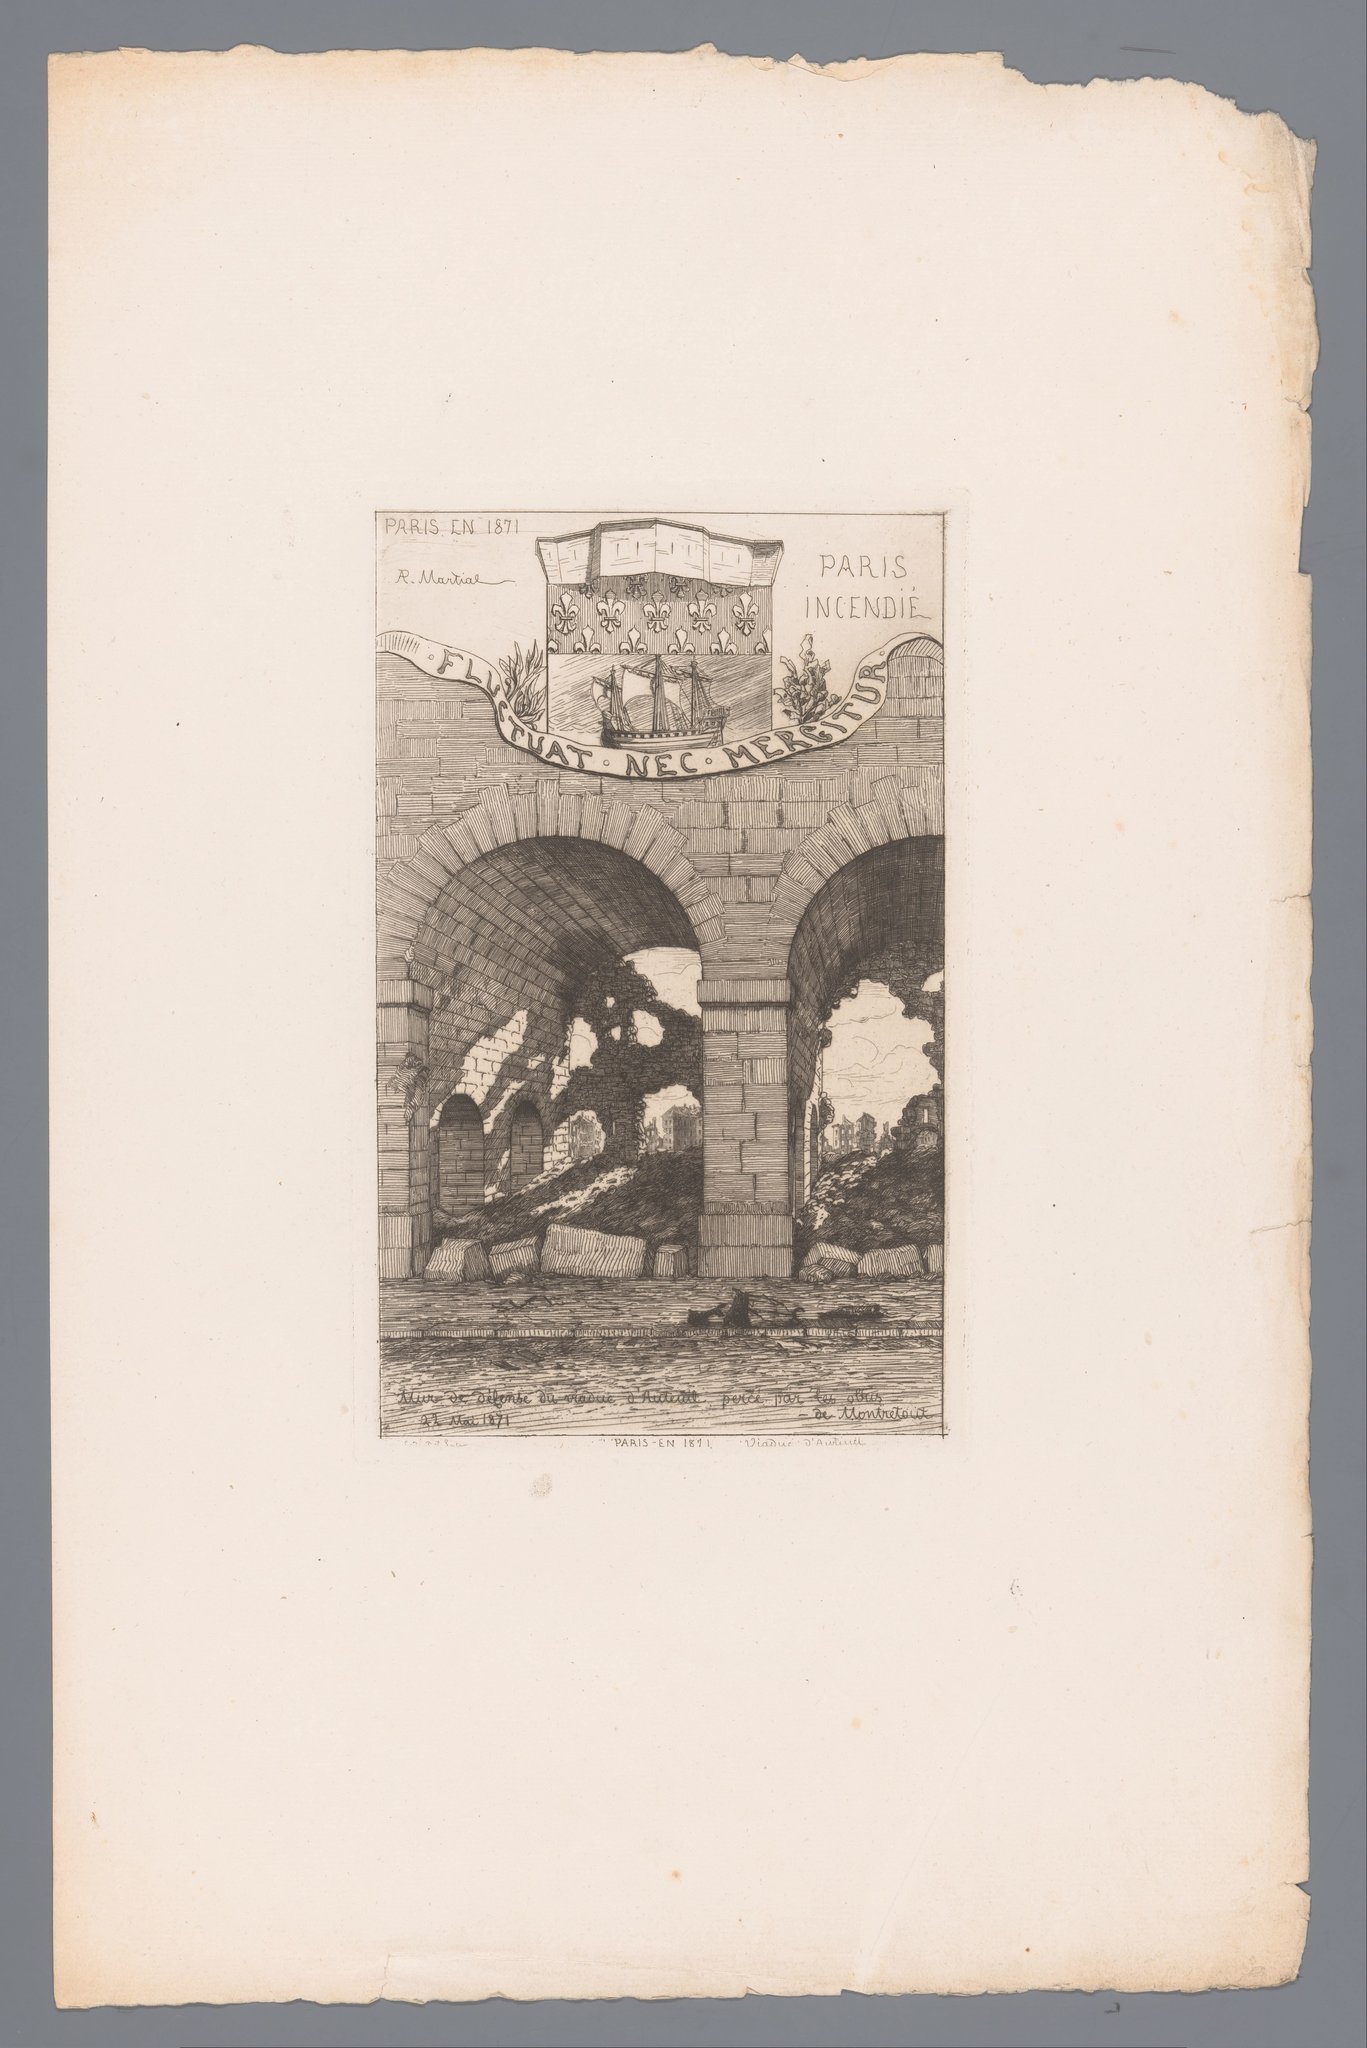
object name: print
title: Paris Incendié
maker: adolphe martial potémont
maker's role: print maker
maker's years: 1828-1883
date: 1871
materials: paper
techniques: etching, intaglio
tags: ruin of a building ~ architecture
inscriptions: collector's mark: Lugt 2228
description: De prent bevindt zich in een omslag en maakt deel uit van een twaalfdelige serie prenten met als onderwerp het brandende Parijs tijdens de Commune in 1871, samengesteld en uitgevoerd door Martial Potémont.